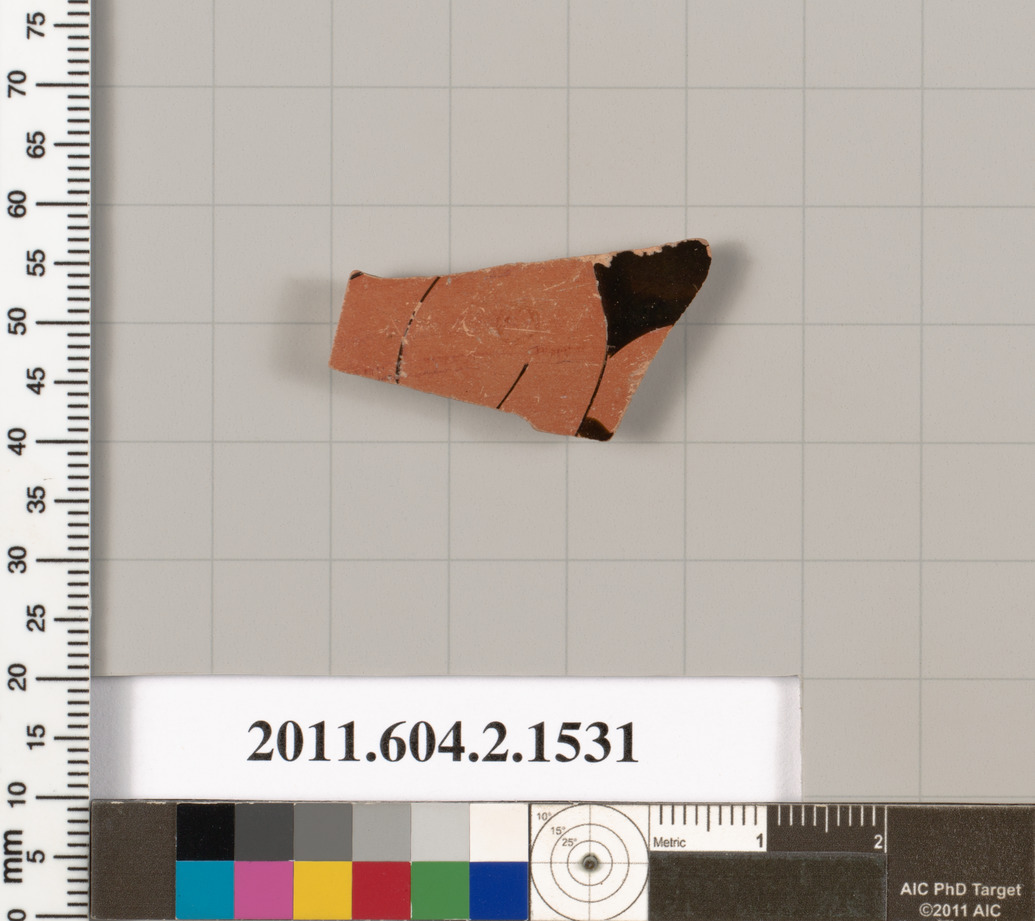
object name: skyphos fragment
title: Terracotta fragment of a skyphos (deep drinking cup)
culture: greek, attic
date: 475-451 BCE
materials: terracotta